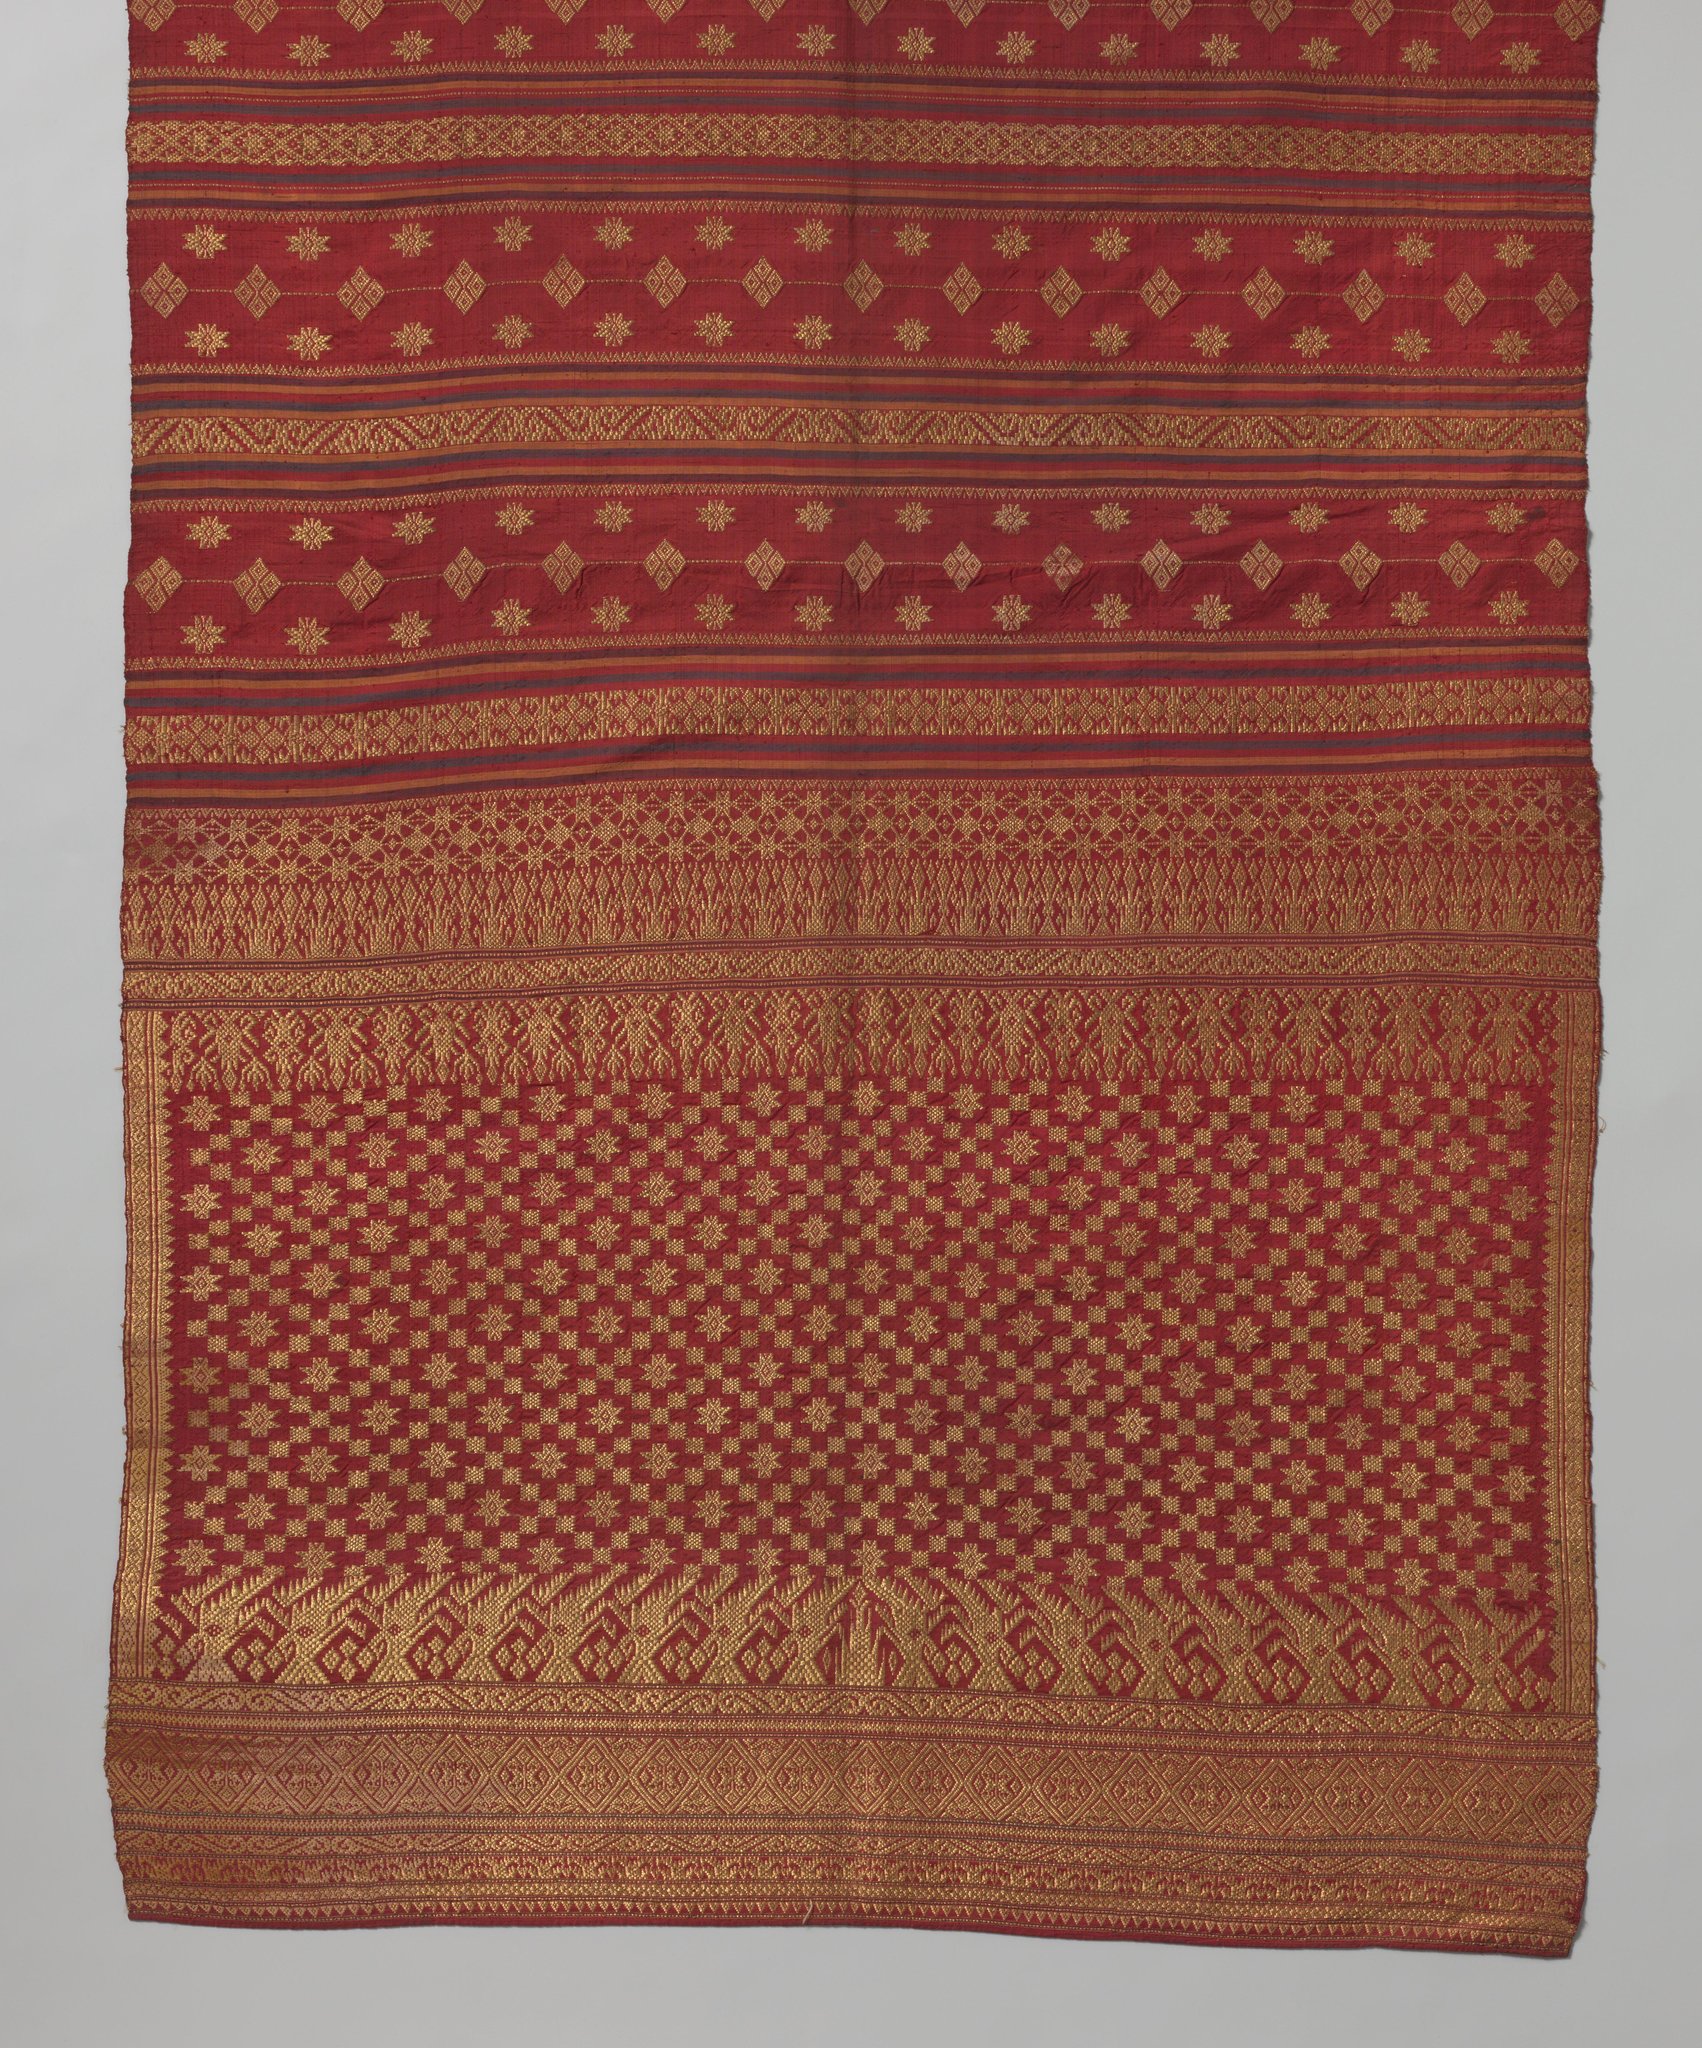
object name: menswear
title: Kaïn van oosterse zijdeweefsel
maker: Anonymous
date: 1400-1850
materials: metal thread, silk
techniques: brocade, weave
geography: sumatra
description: Kaïn van rode zijde met een in gouddraad geweven decor. Het middenveld versierd met het z.g. `Bintang patroon'. Aan de smalle zijden een brede rijkversierde rand.